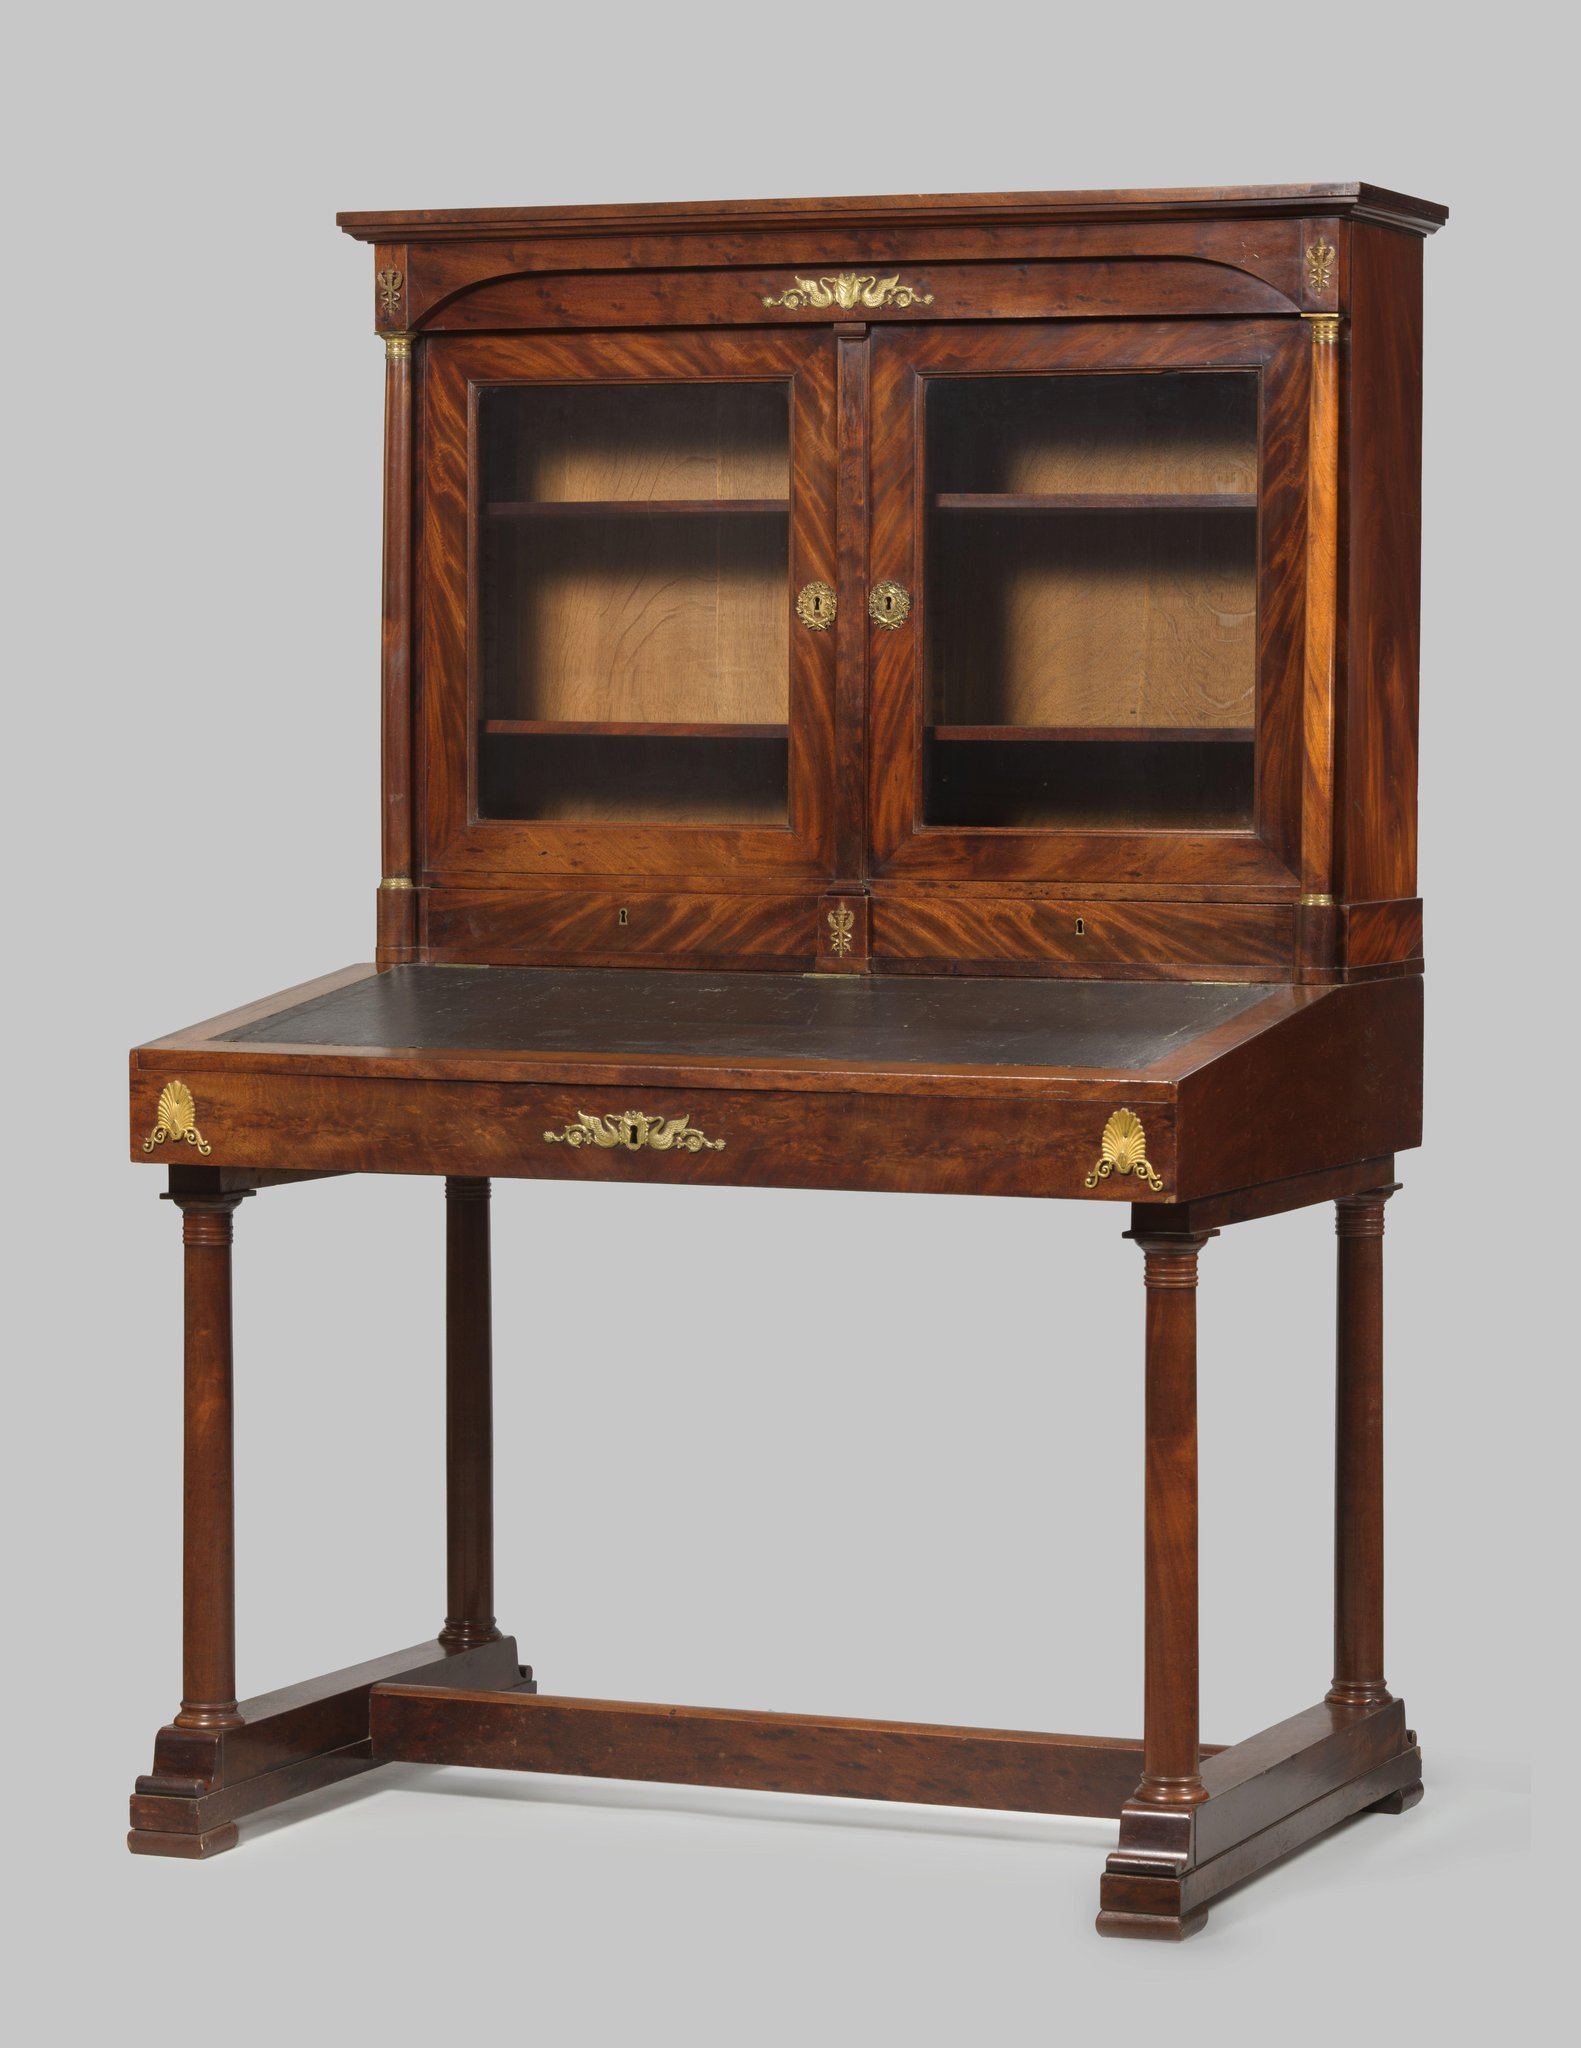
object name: desk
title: Bureautafel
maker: Anonymous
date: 1820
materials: copper, glass, leather, wood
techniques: gilding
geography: northern netherlands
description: Eikenhouten bureau belijmd met mahoniehout, met beslag van verguld koper. Het schuin gestelde schrijfblad is het deksel van een bergruimte, rustend op vier Toscaanse zuilen op sledevoeten waartussen een dwarsbalk. De voorregel draagt beslag in de vorm van palmetten en een plaat met zwanen, ranken en schild. De opstand heeft twee deuren met glas en laden, geplaatst tussen zuilen op een rond basement. In de kap erboven zitten huizen met beslag, waartussen een blinde toog met beslag als op de voorregel.